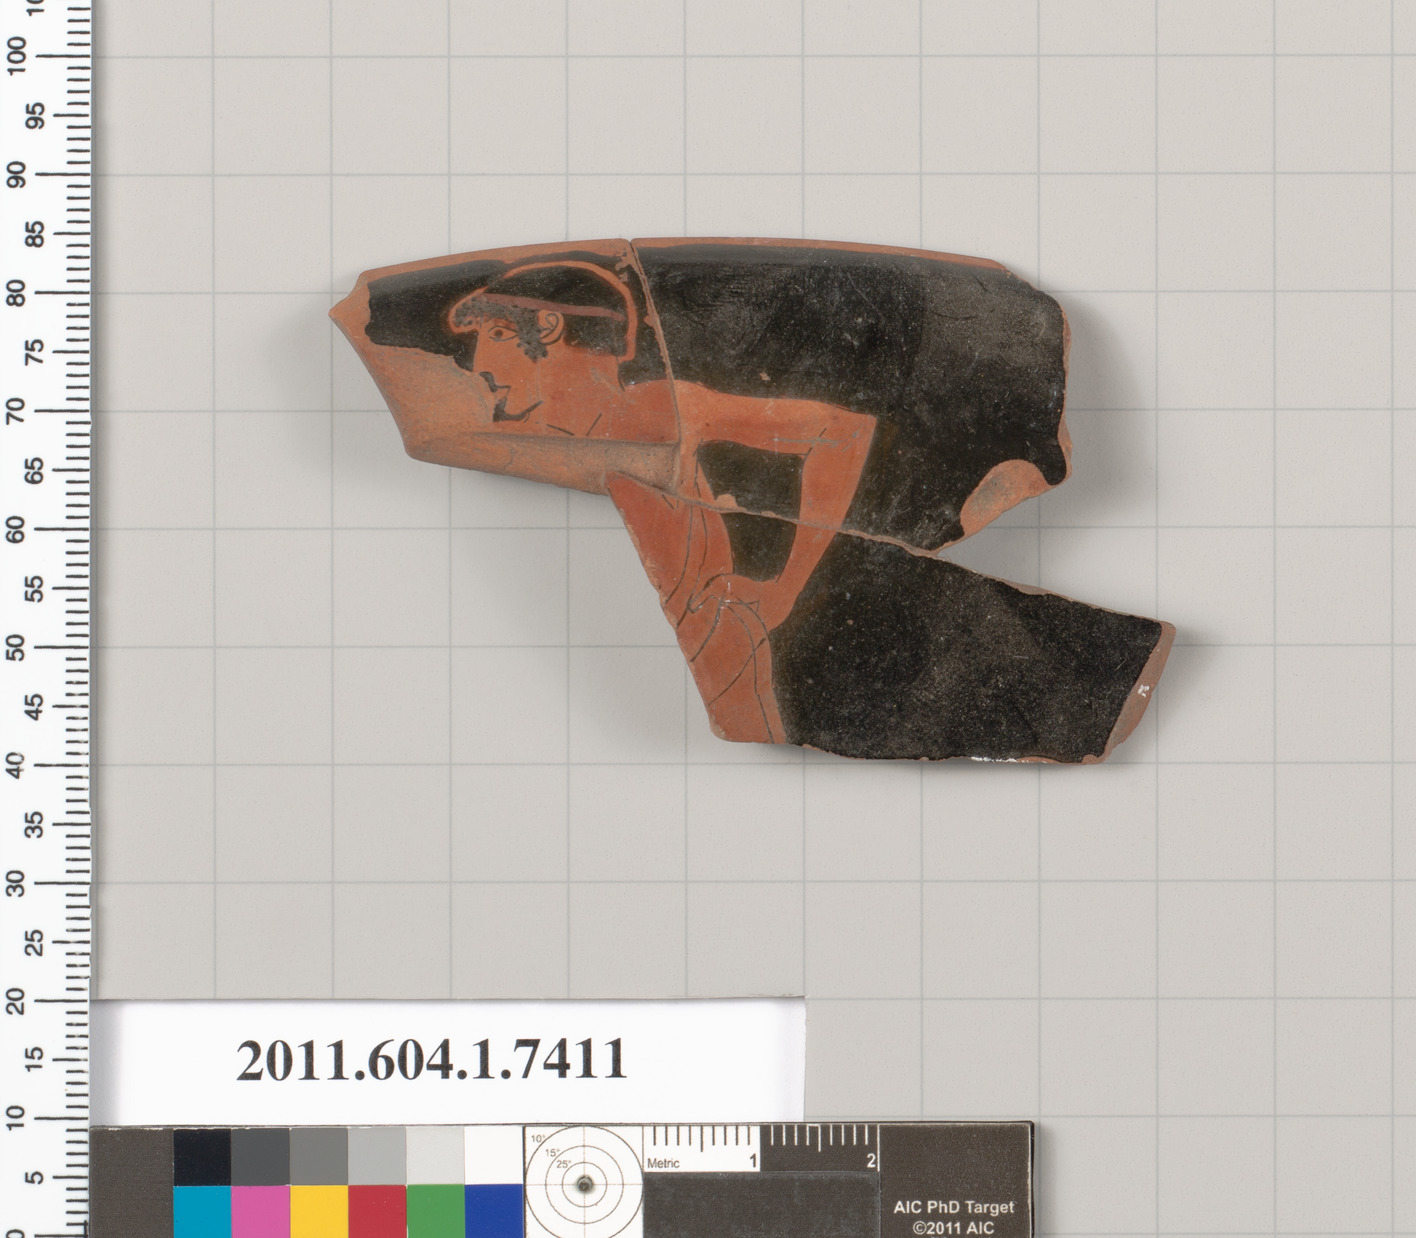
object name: kylix fragment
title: Terracotta rim fragment of a kylix (drinking cup)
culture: greek, attic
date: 490-470 BCE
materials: terracotta